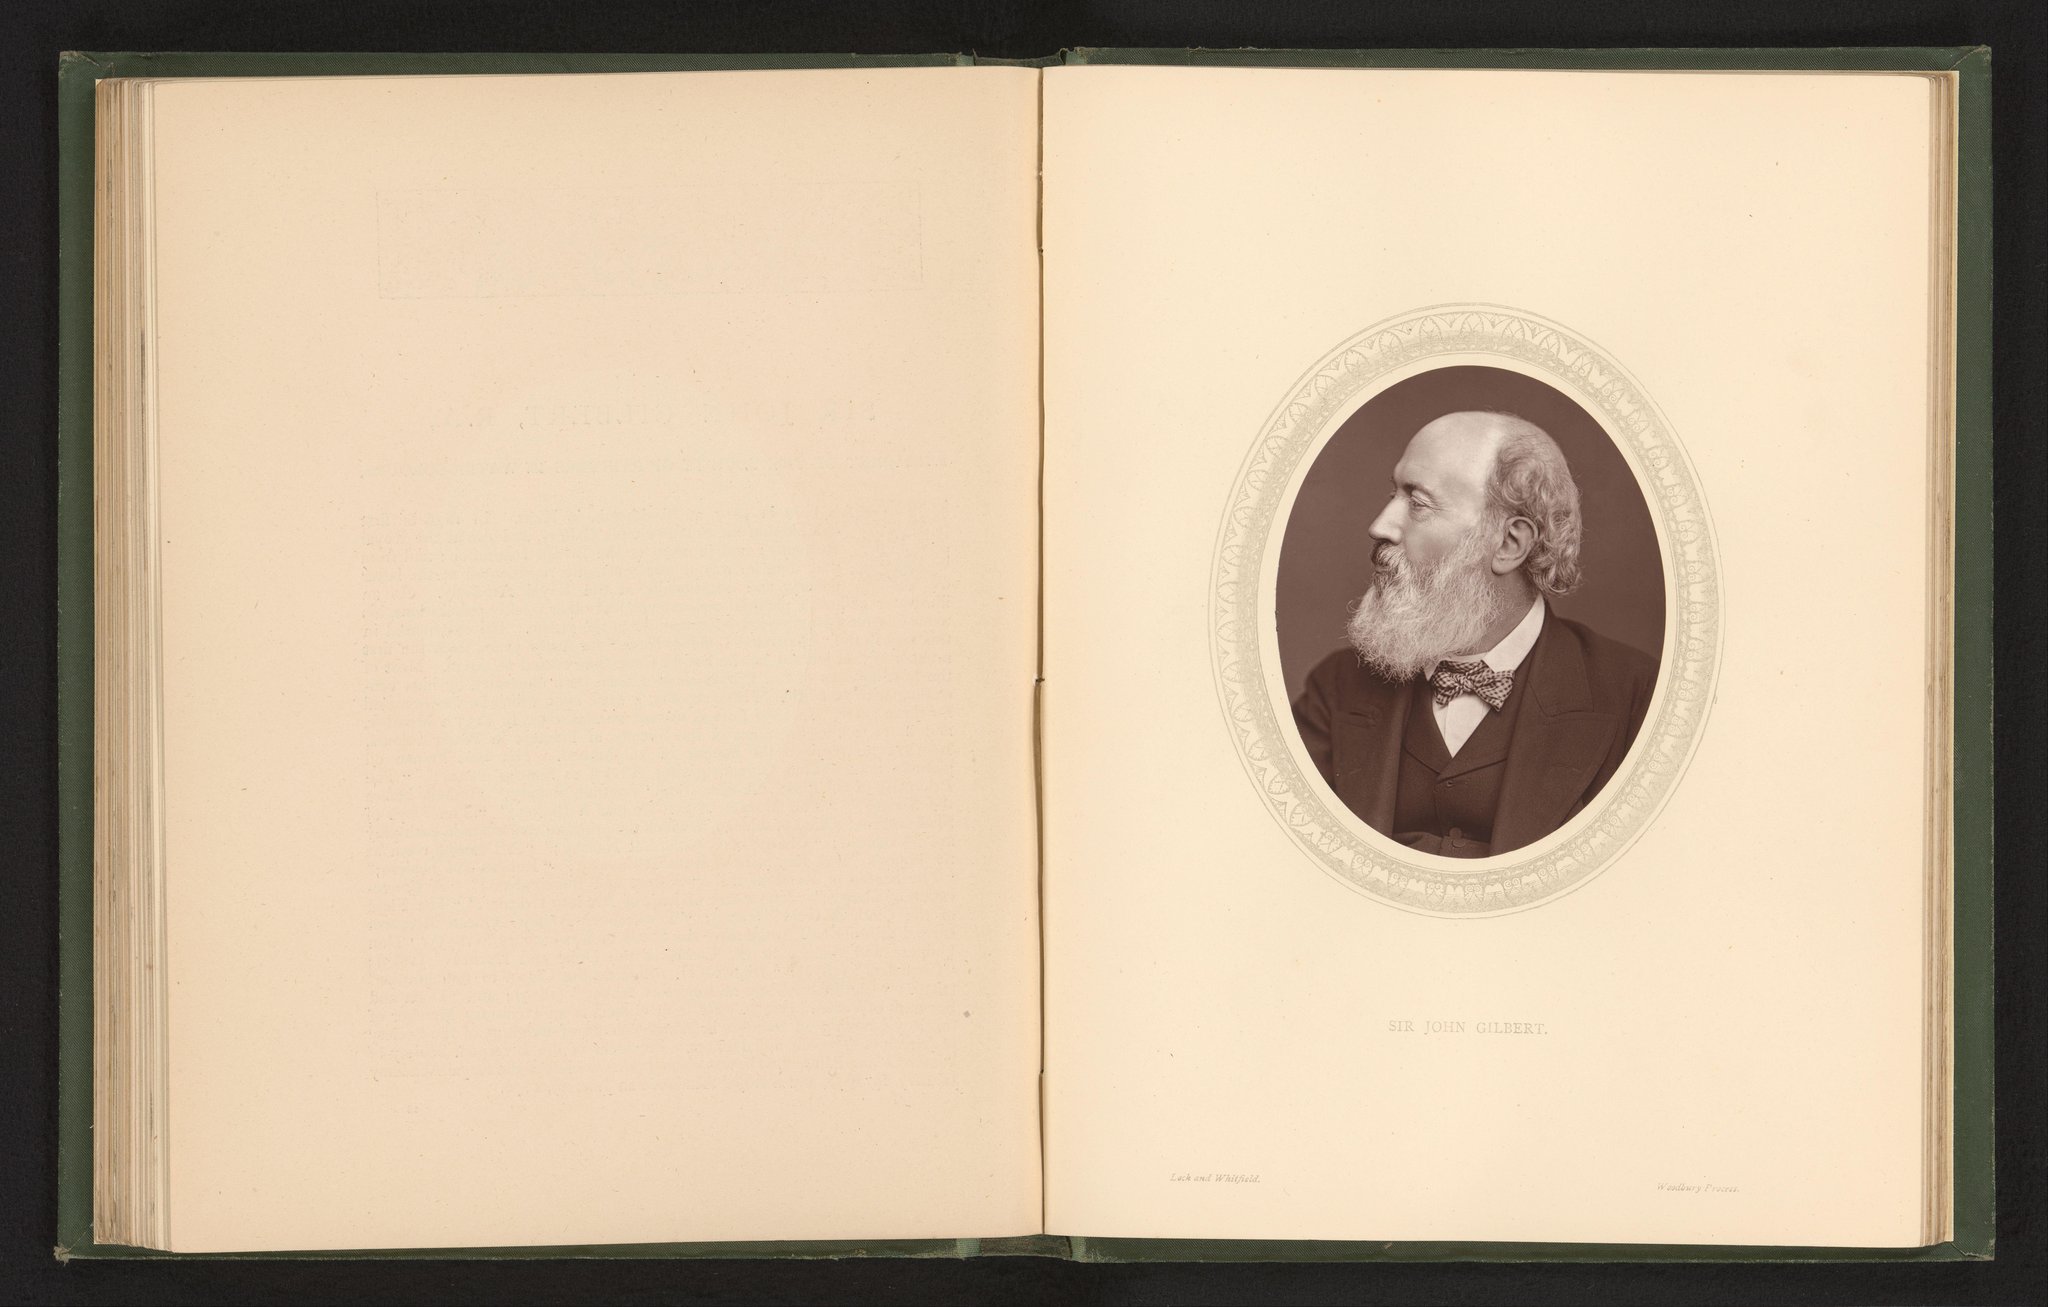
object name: photomechanical print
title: Sir John Gilbert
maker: Anonymous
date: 1872-1877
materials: paper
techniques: woodburytype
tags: painter, john gilbert, portrait, self-portrait of painter, historical persons (portraits and scenes from the life) (+ (full) bust portrait)